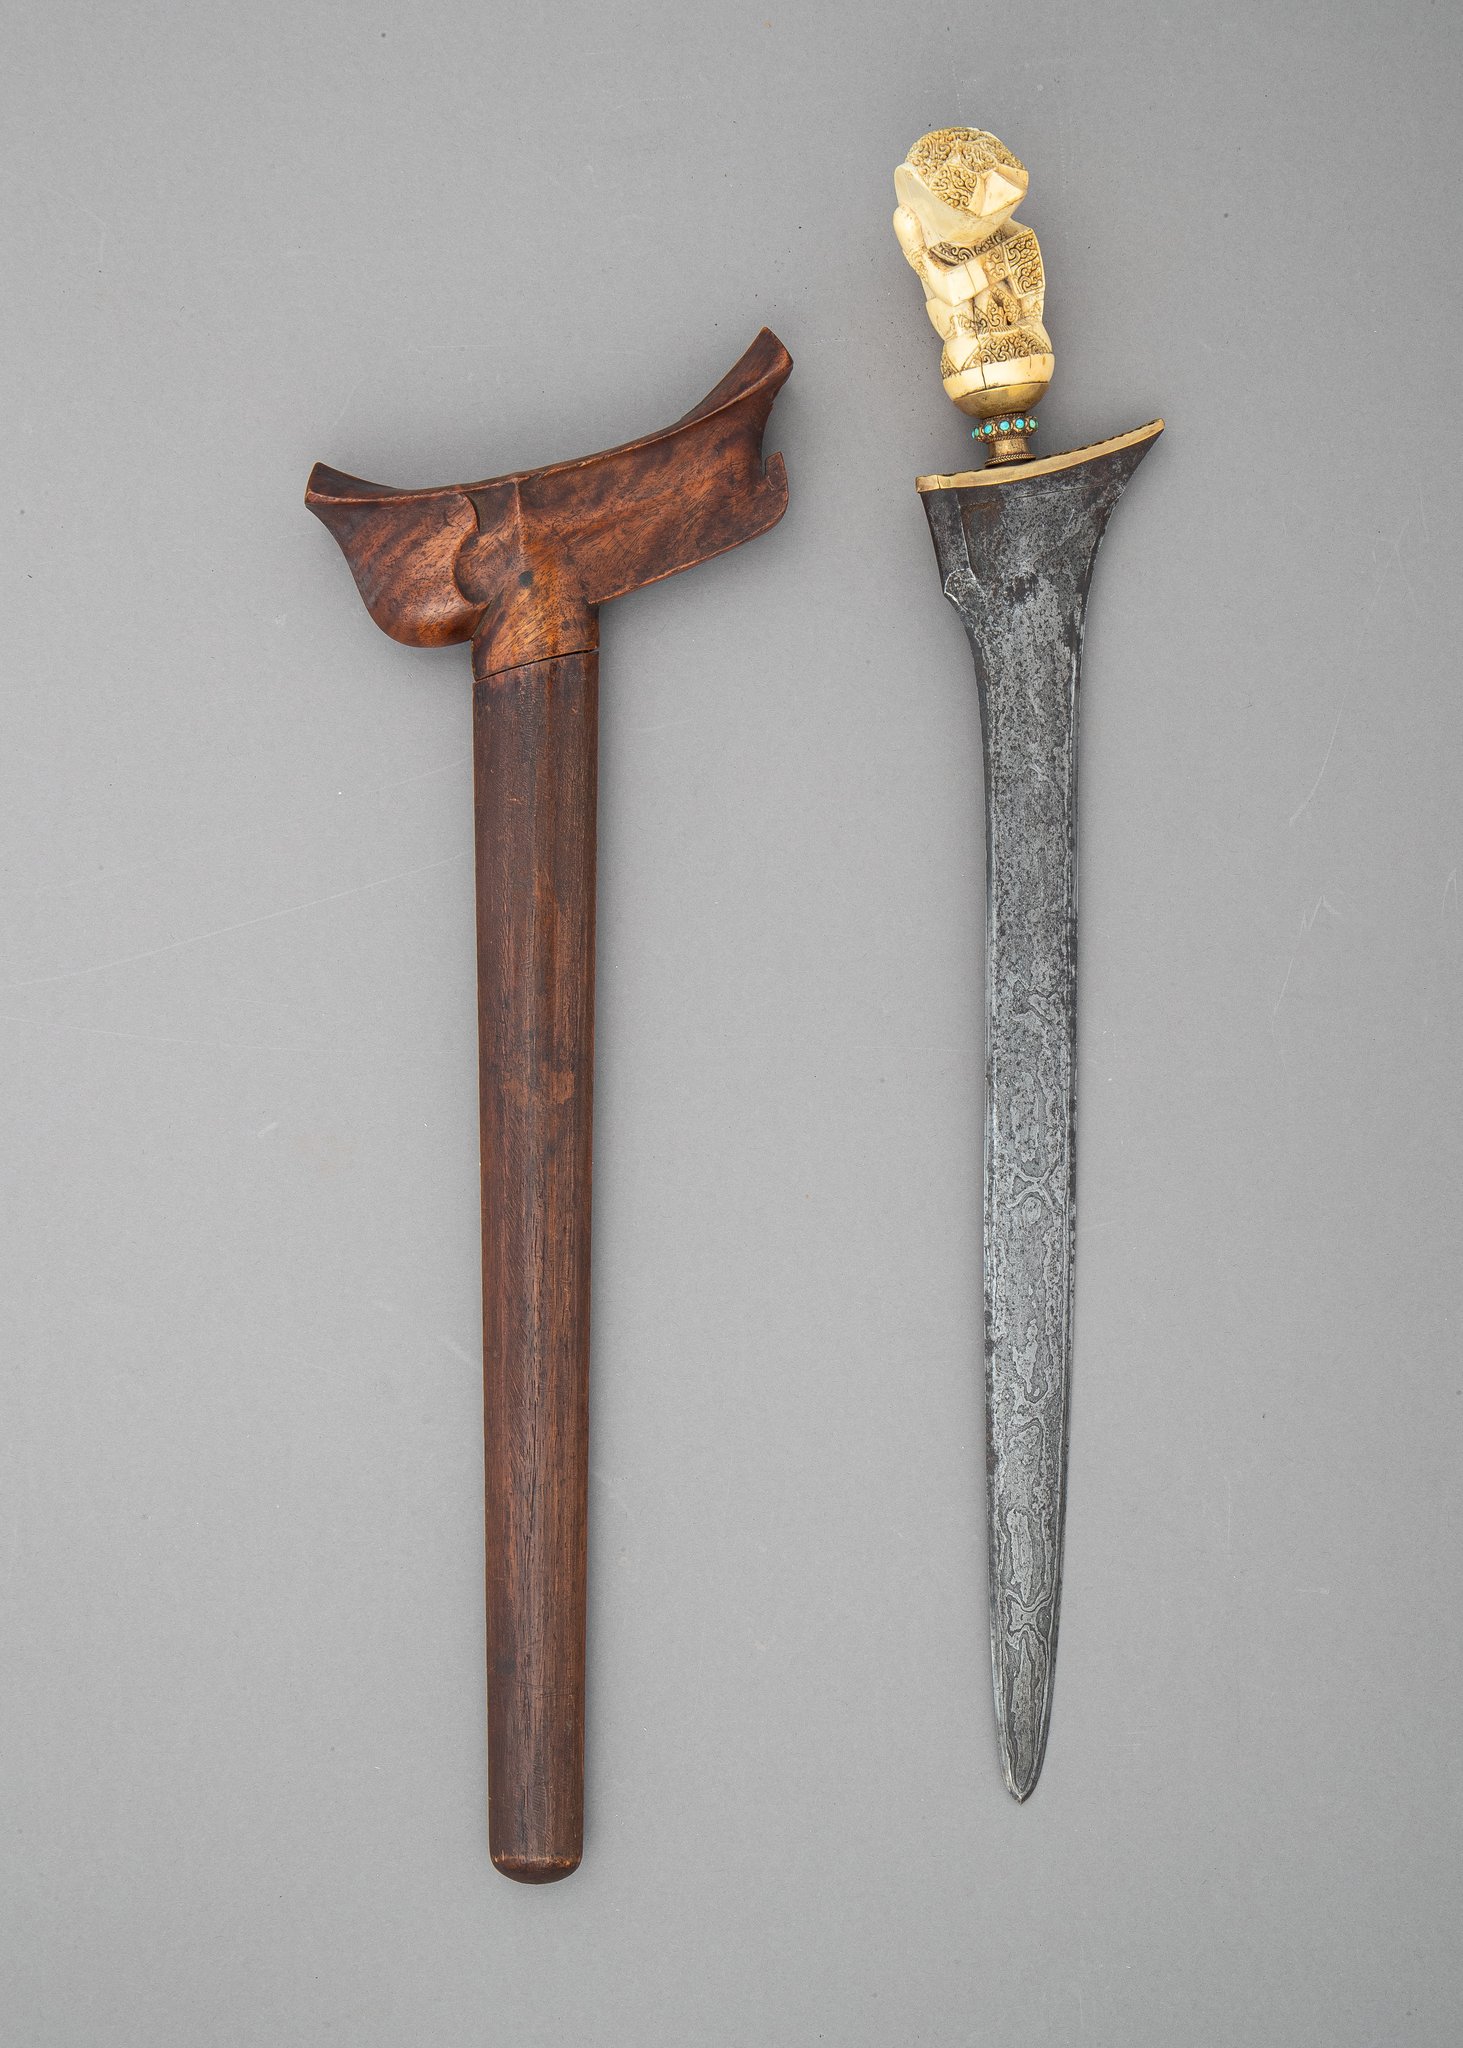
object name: kris with sheath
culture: sumatran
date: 1501-1900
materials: gold, ivory, steel, wood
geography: indonesia